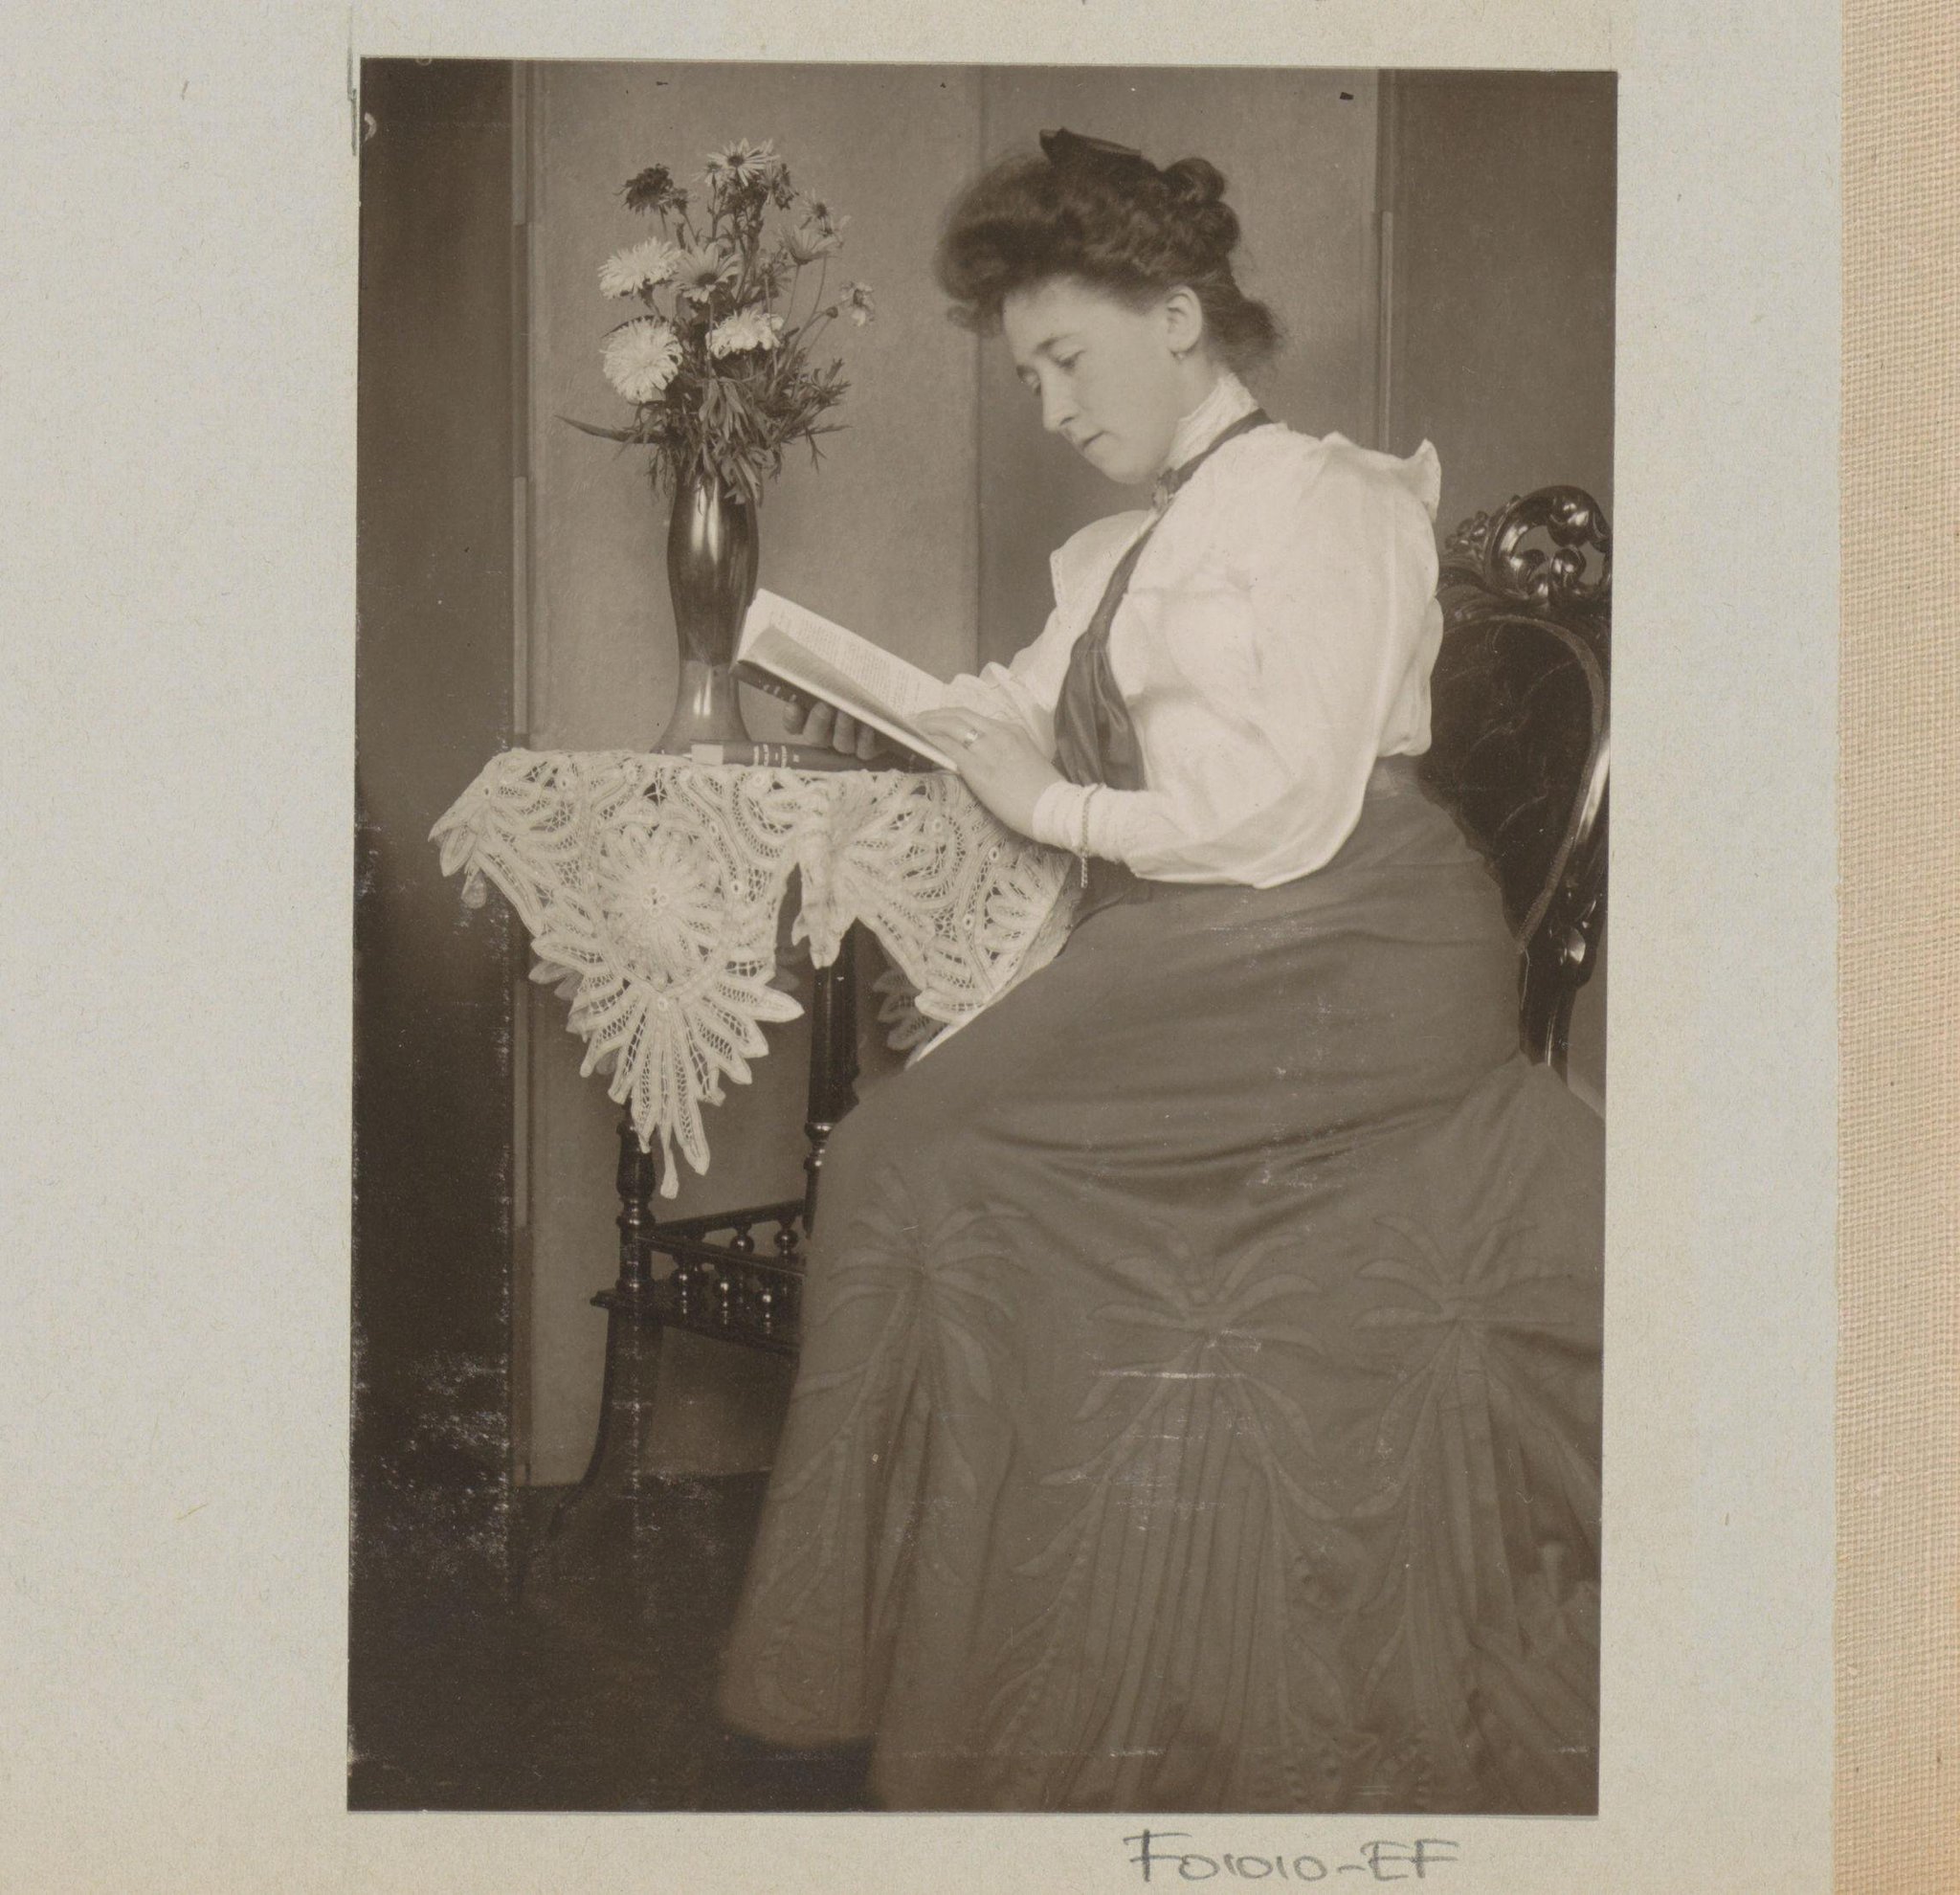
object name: photograph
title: Boeklezende vrouw zittend aan een tafel met een vaas bloemen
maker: Anonymous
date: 1900-1910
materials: photographic support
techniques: matte daylight collodion silver print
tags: cut flowers; nosegay, bunch of flowers, reading, anonymous historical person portrayed - bb - woman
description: Onderdeel van Familiealbum met onder meer foto's van Wijnhandel Kraaij & Co. Bordeaux-Amsterdam.